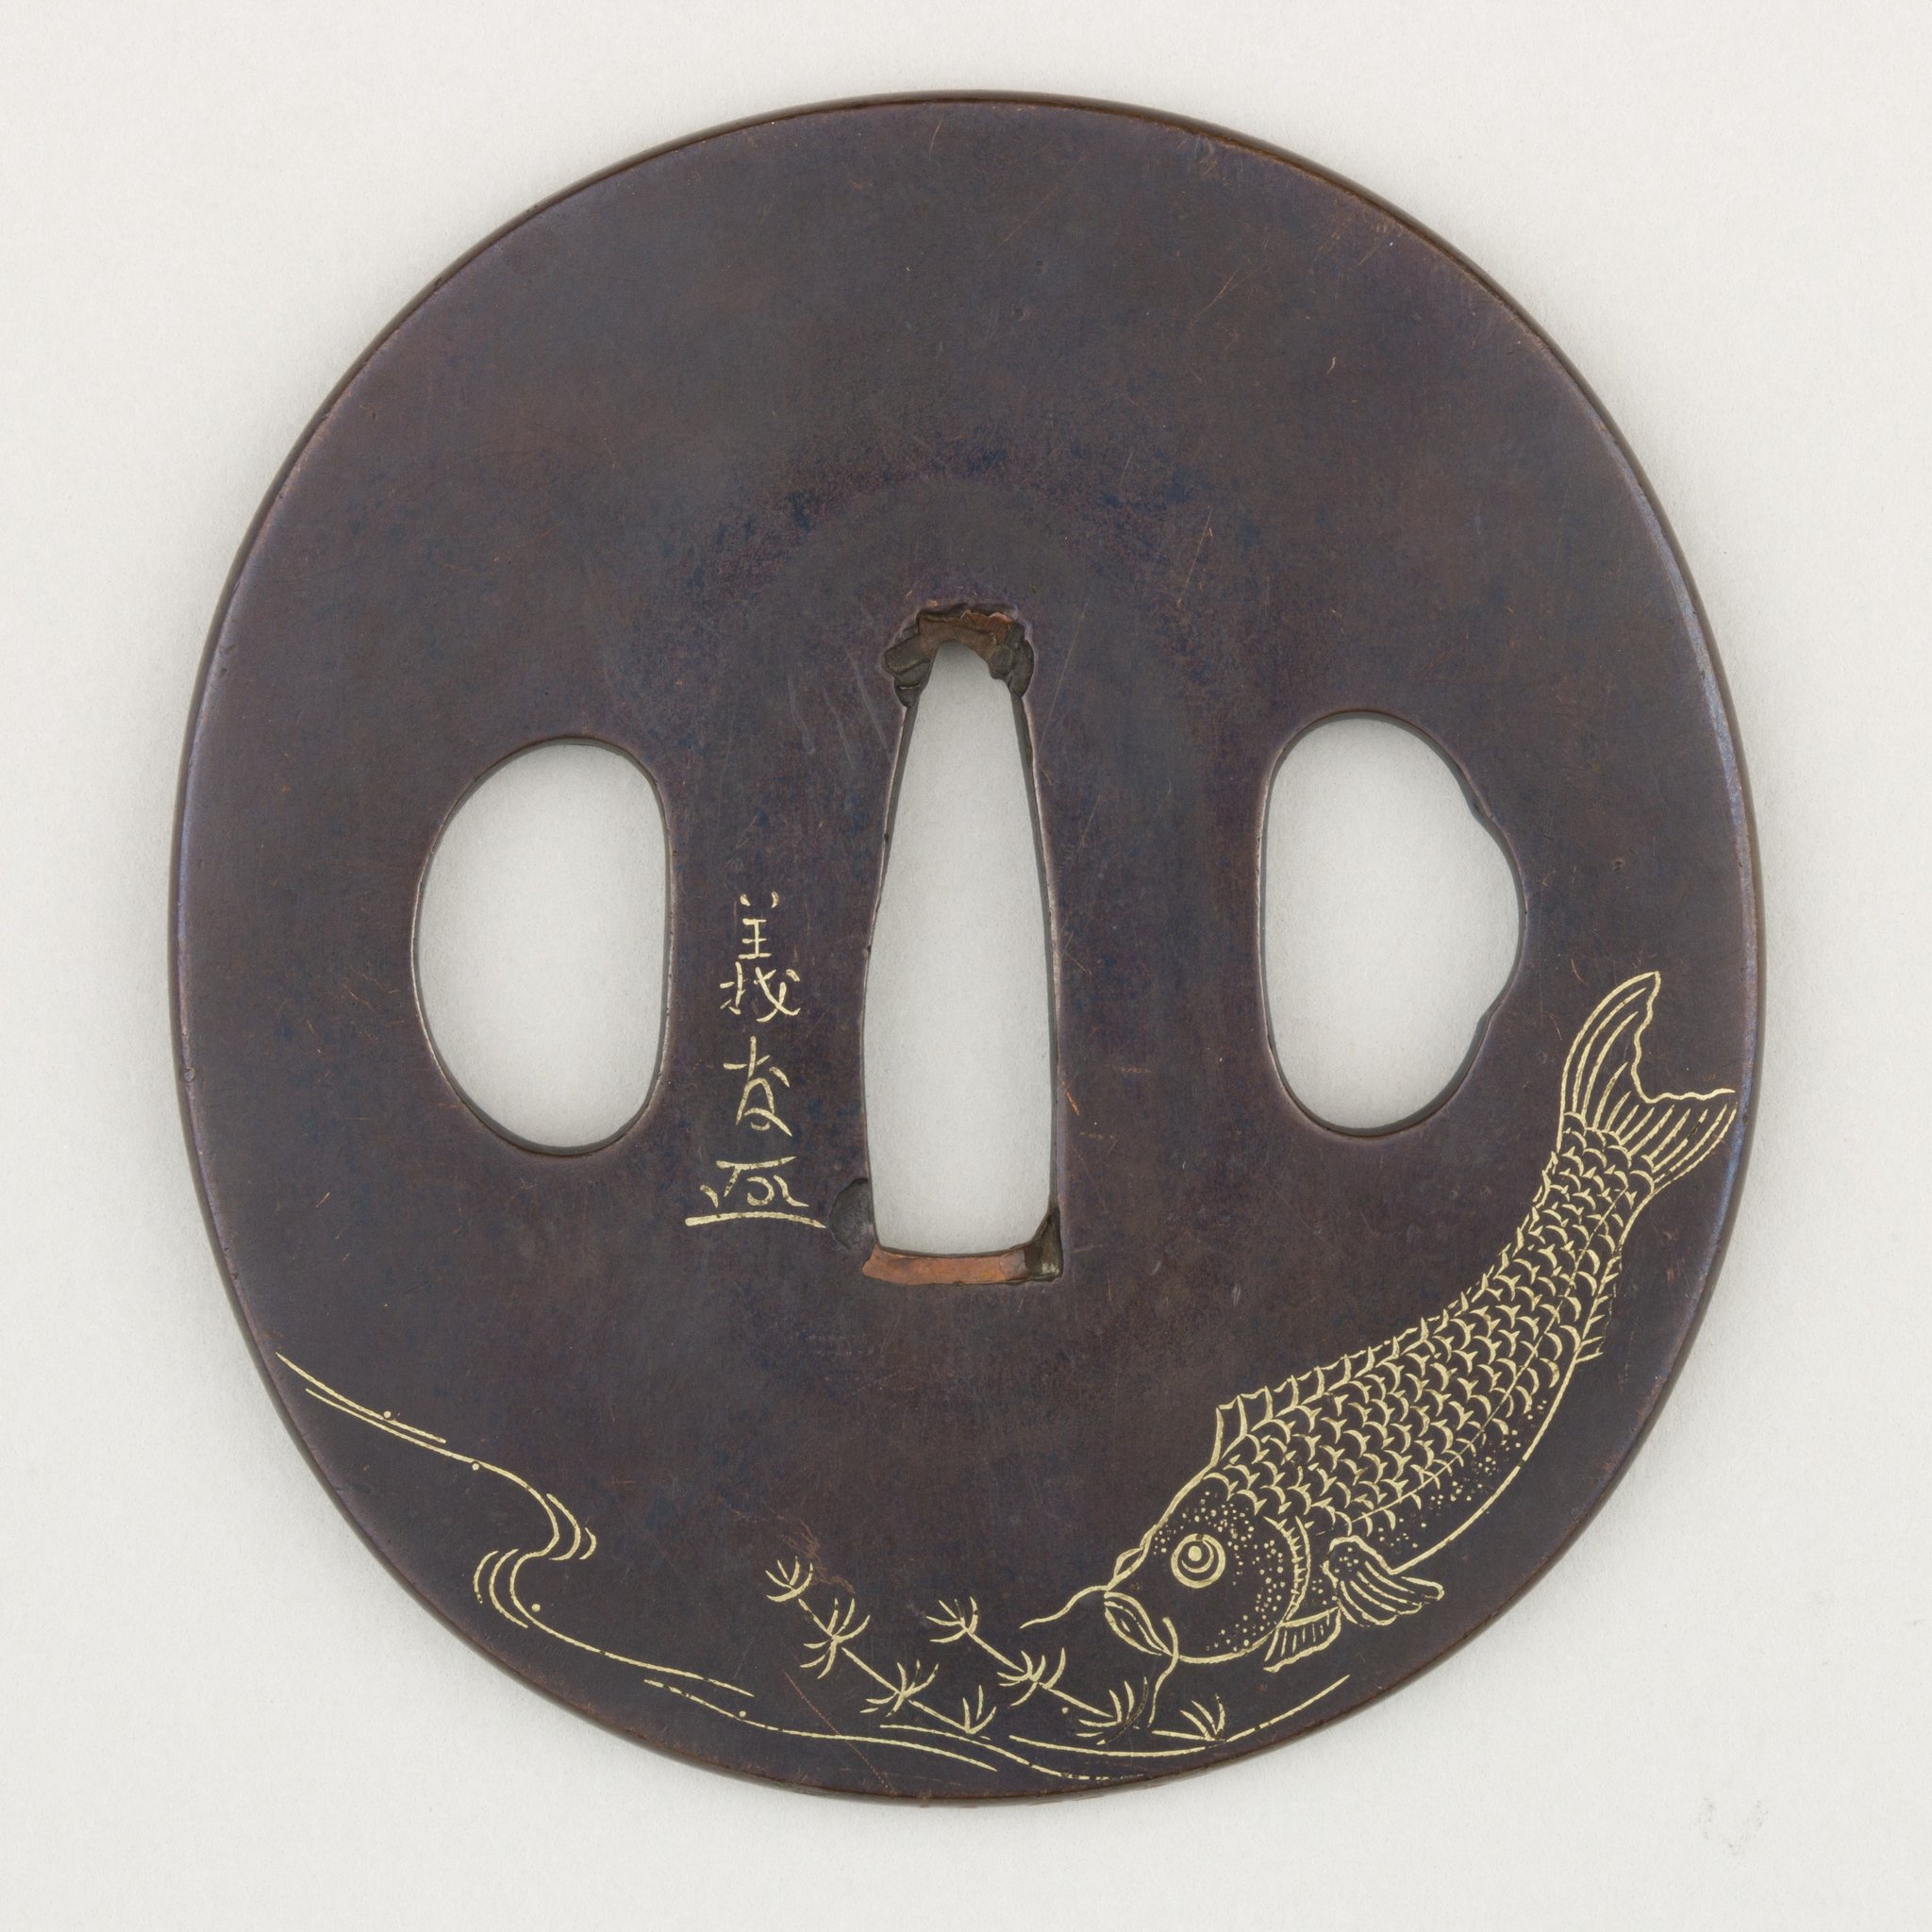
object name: sword guard tsuba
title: Sword Guard (Tsuba)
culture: japanese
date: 1801-1833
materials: copper, gold alloy, gold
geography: japan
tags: fish